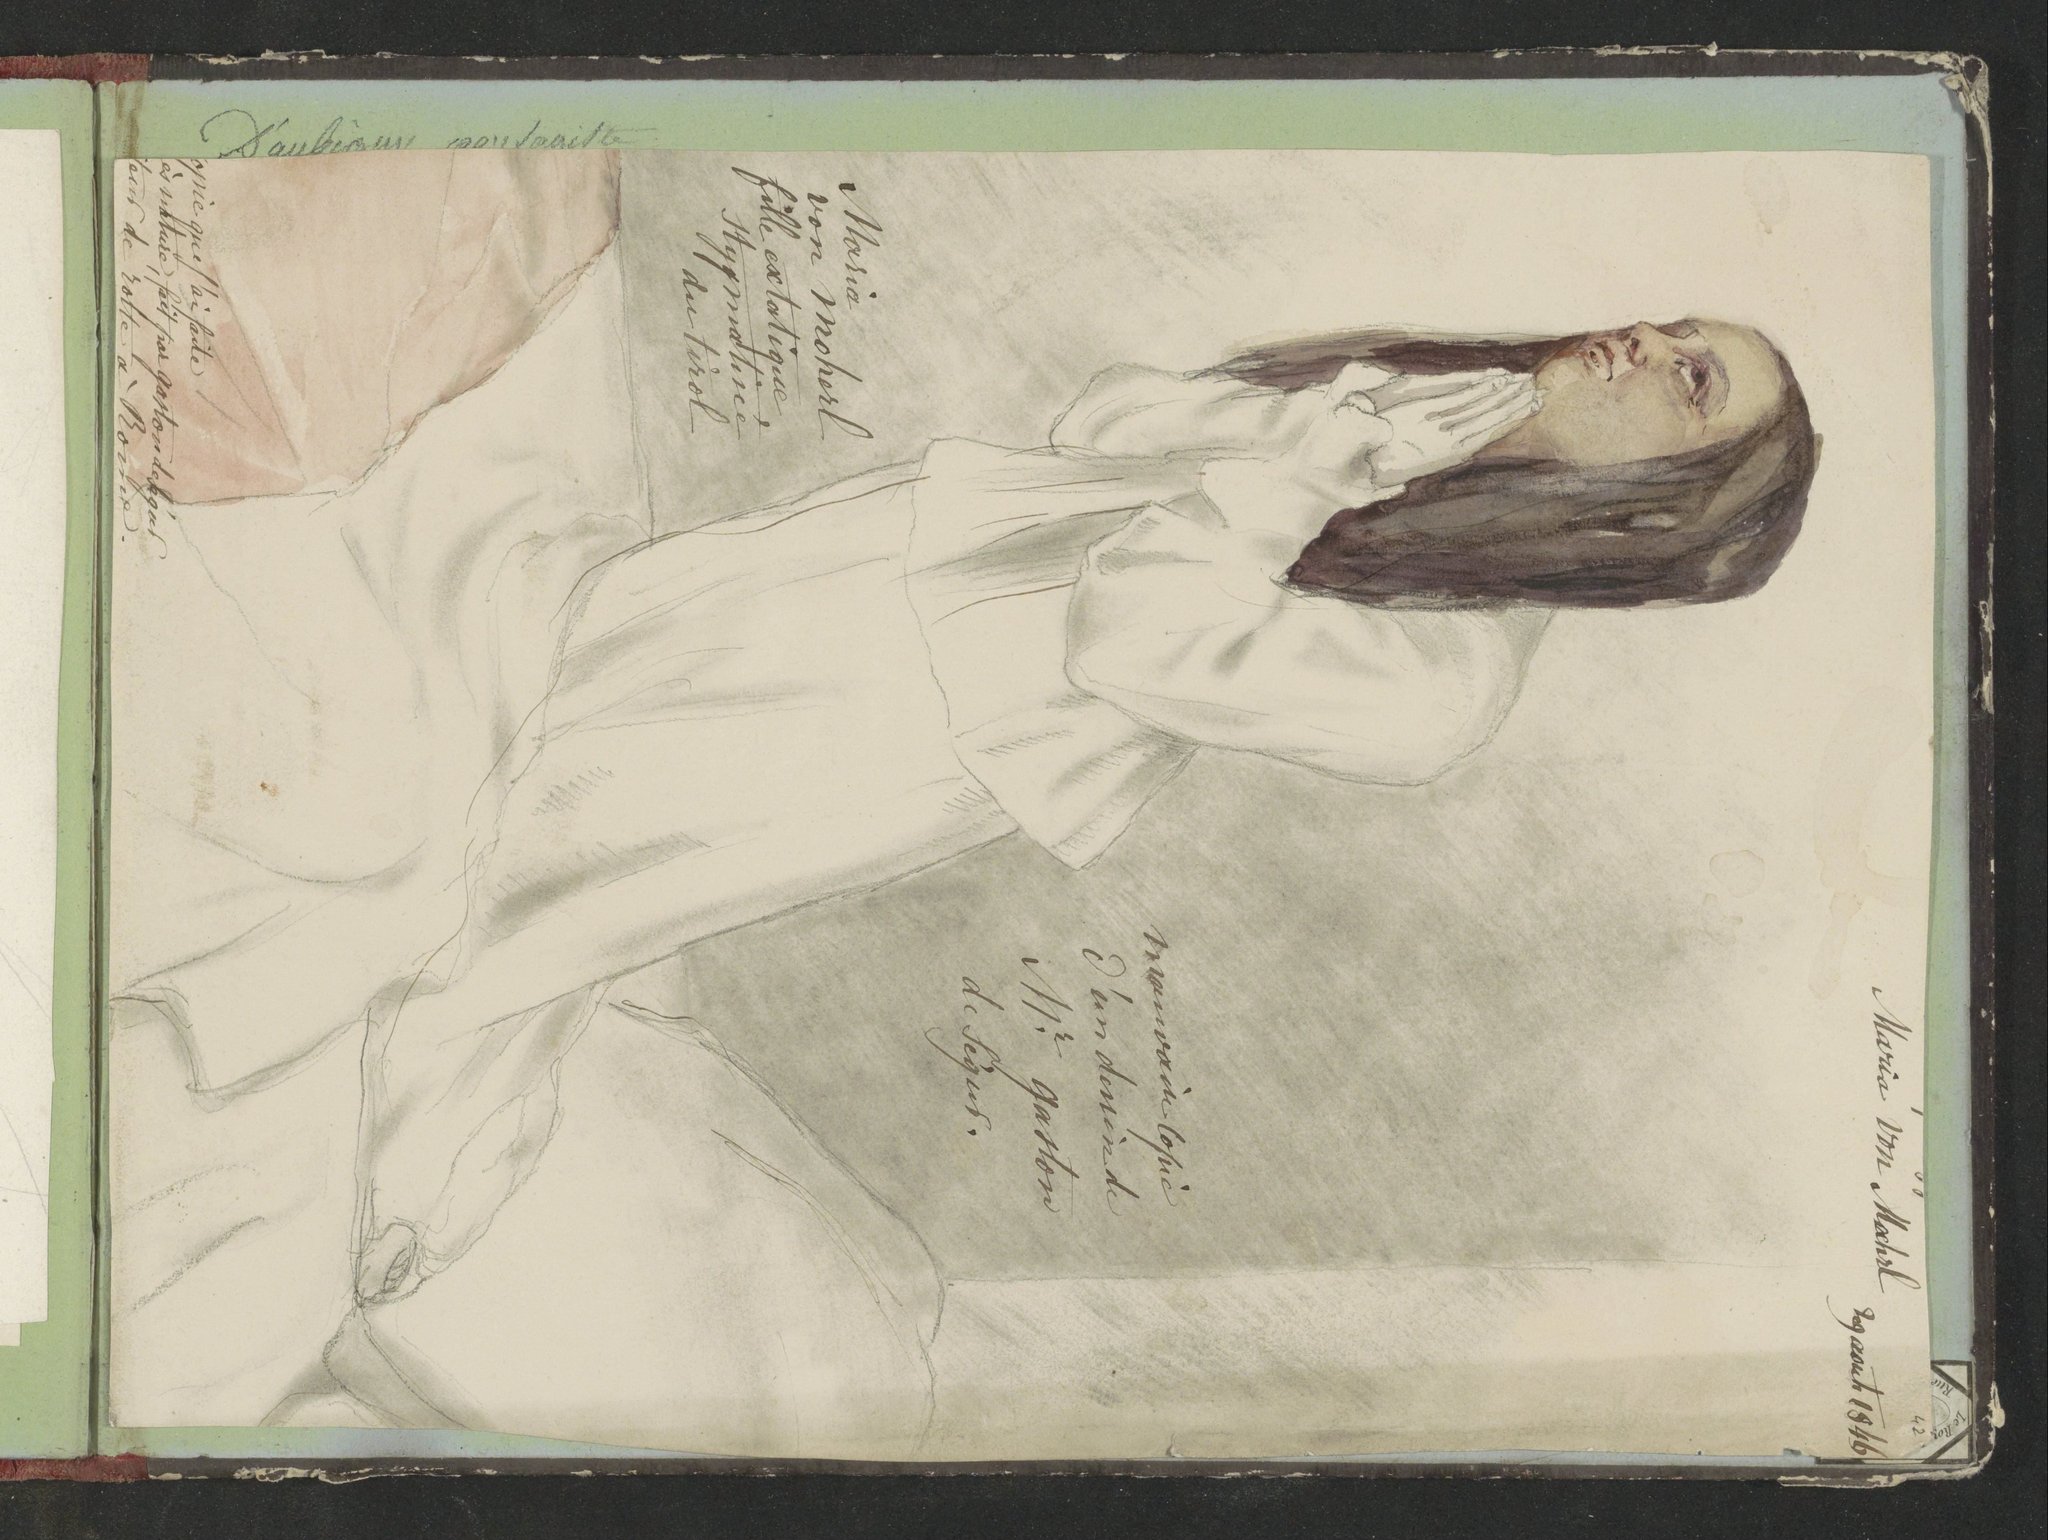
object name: sketchbook leaf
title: Stigmatisering van Maria von Mörl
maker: chantal de luçay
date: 1808-1846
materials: paper, pencil, watercolor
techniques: brush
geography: vineuil-saint-firmin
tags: kneeling figure - aa - female human figure, stigmatization, stigmata, kneeling figure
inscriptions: date and inscription: ‘Maria von Moehrl/ 29 aout 1846/ mauvais copie d'un dessin de/ Mr gaston/ de segur/ Maria/ von Moherl/ fille extatique/ stygmatisée/ du tirol / copie que j'ai faite/ [...]ès nature, fait par gaston de ségur/ [...]’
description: Maria von Mörl zit geknield op een bed met haar handen gevouwen onder de kin en ontvangt de stigmata. Recto van blad 42, een losse tekening uit een schetsboek met 39 bladen.